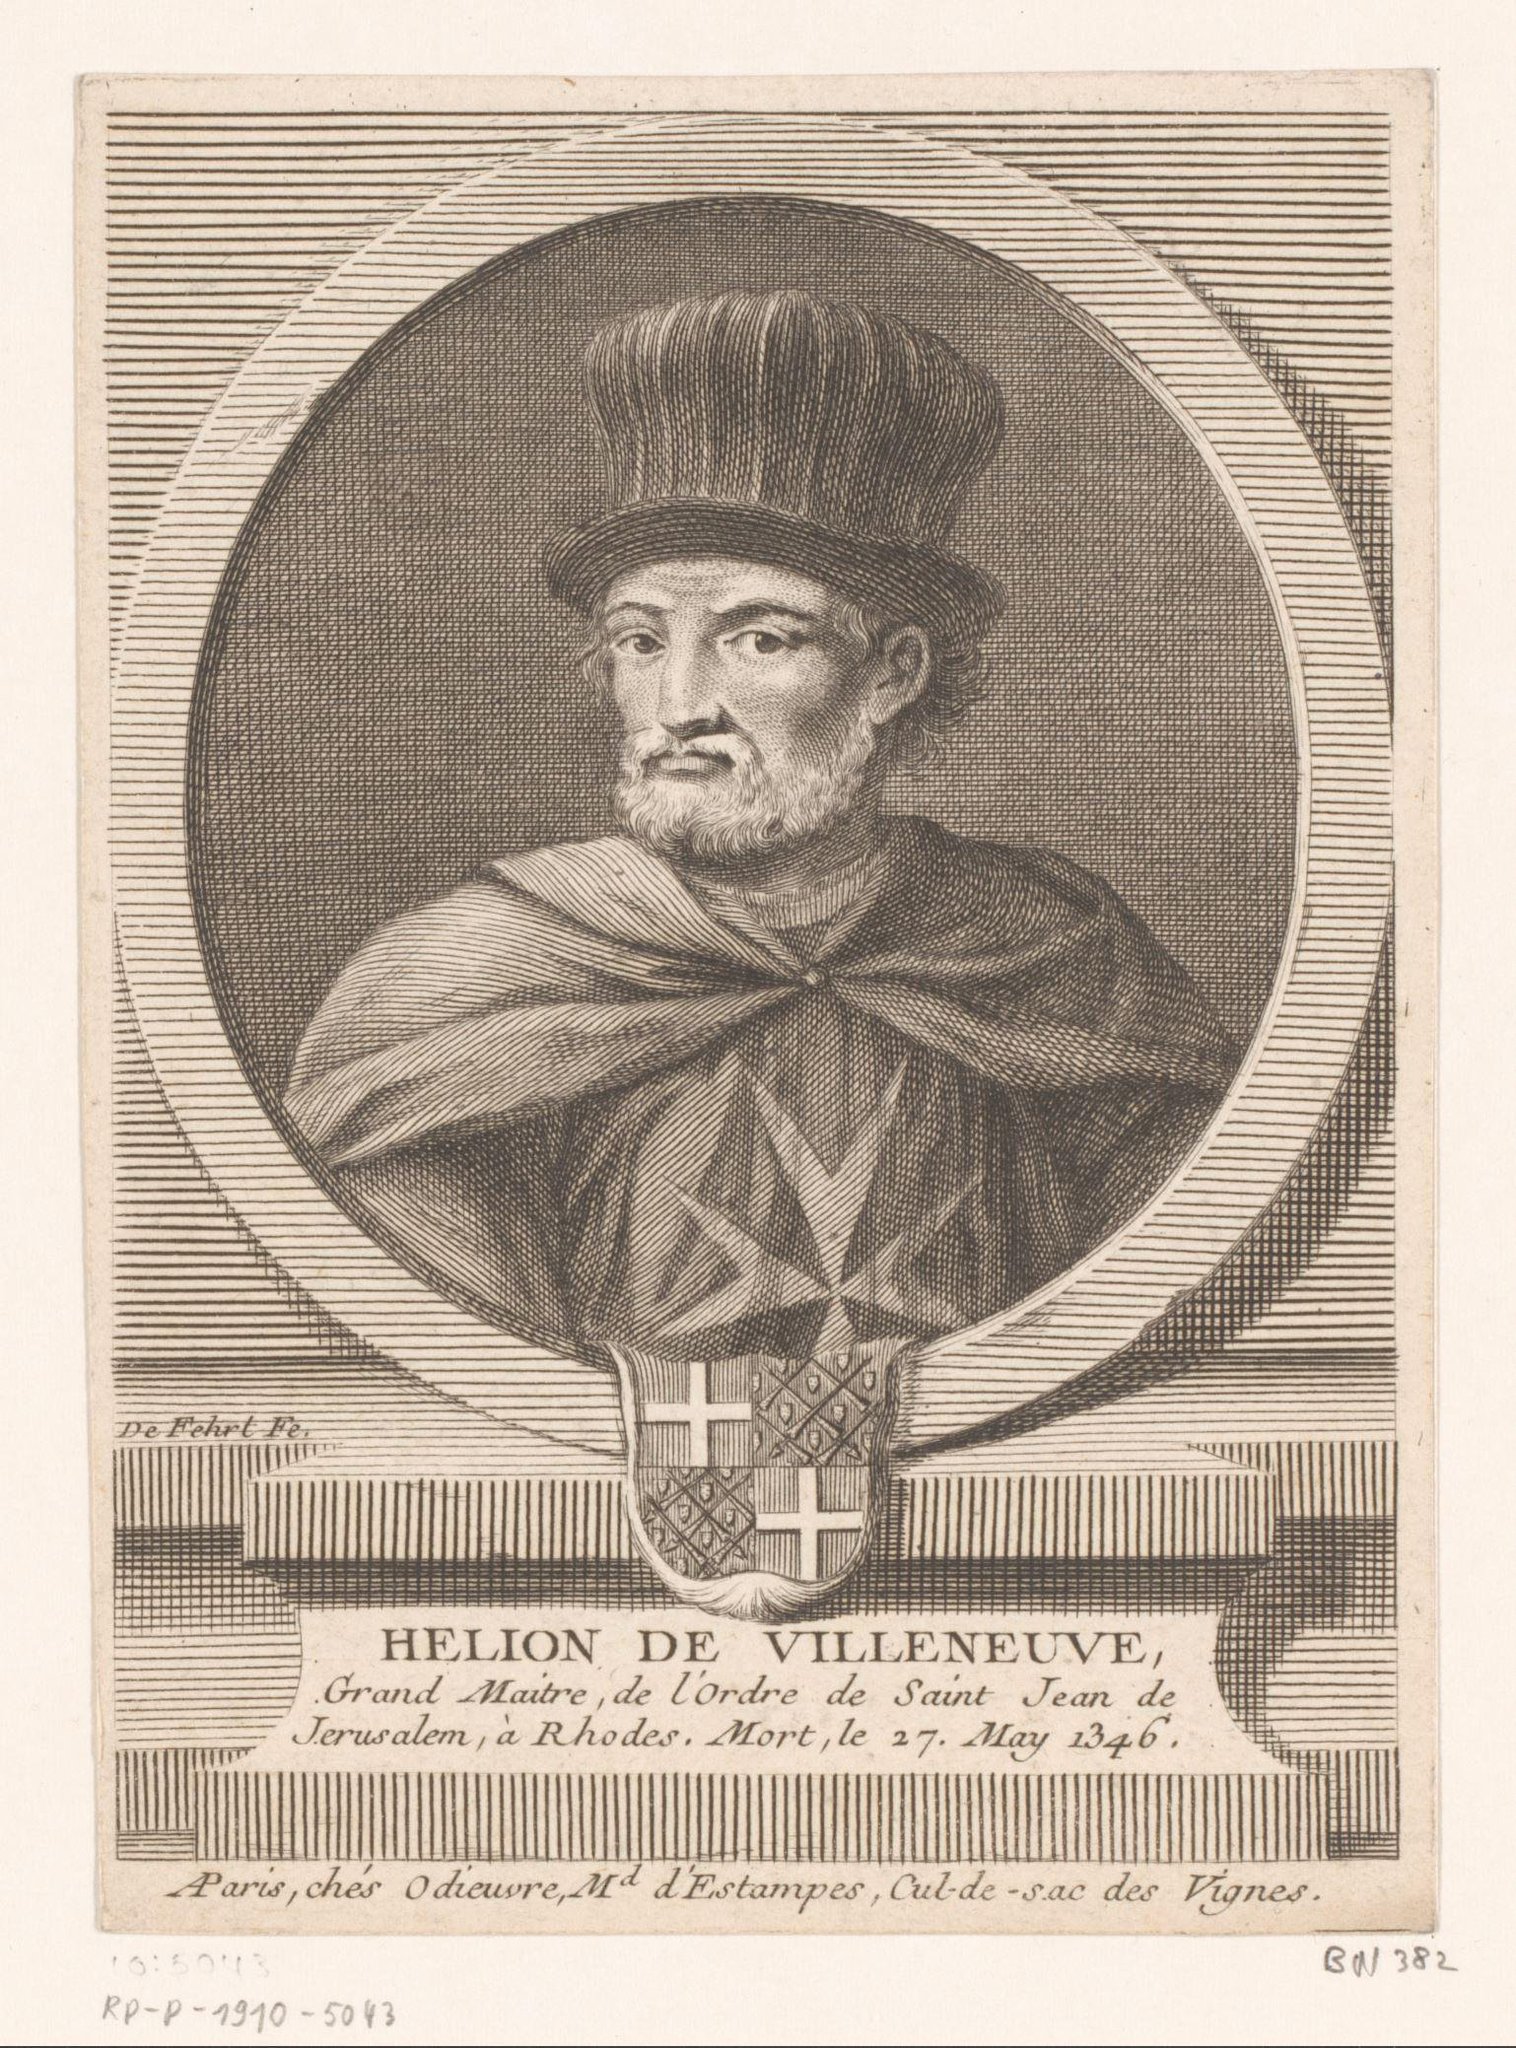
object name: print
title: Fil, Rouët, Dévidoirs.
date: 1765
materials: paper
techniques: etching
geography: france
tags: spinning-wheel (+ technical aspects ~ crafts, industries, agriculture), spinning-wheel (+ women (labourers))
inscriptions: collector's mark: Lugt 2228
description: Prent uit: Diderot, Denis. Encyclopédie ou dictionnaire raisonné des sciences, des arts et des métiers. Parijs: David Briasson en Durand Le Breton, 1765.